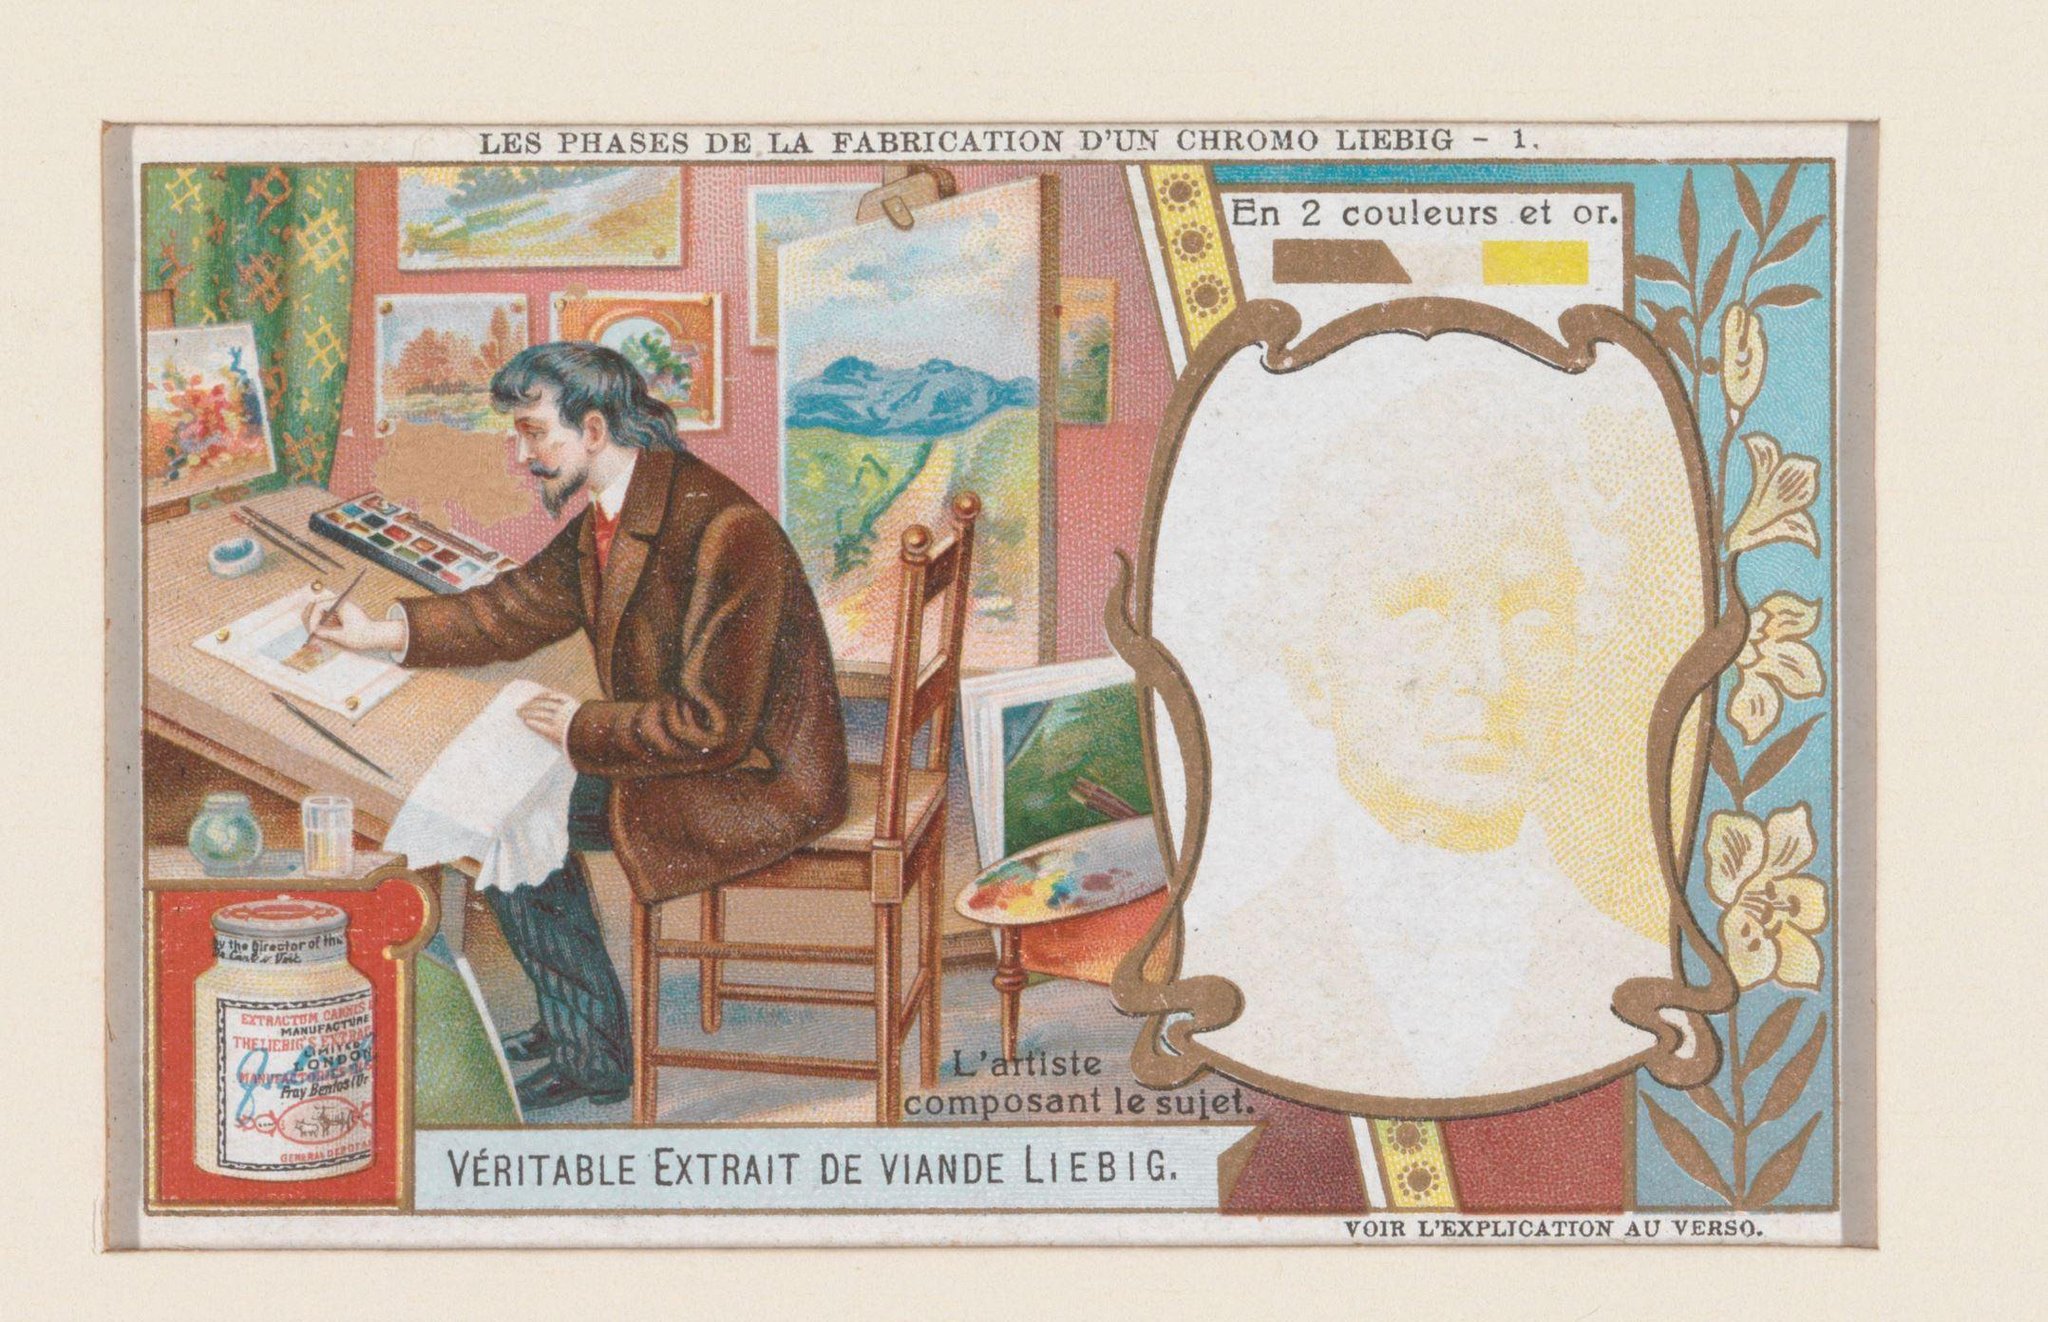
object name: print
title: L'artiste composant son sujet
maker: Anonymous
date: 1906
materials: paper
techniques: chromolithography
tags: historical persons, workshop, studio of the artist (in general)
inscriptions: title: ‘VÉRITABLE EXTRAIT DE VIANDE LIEBIG.’, title: ‘L'artist composant son sujet’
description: De kunstenaar maakt een ontwerp in zijn atelier.